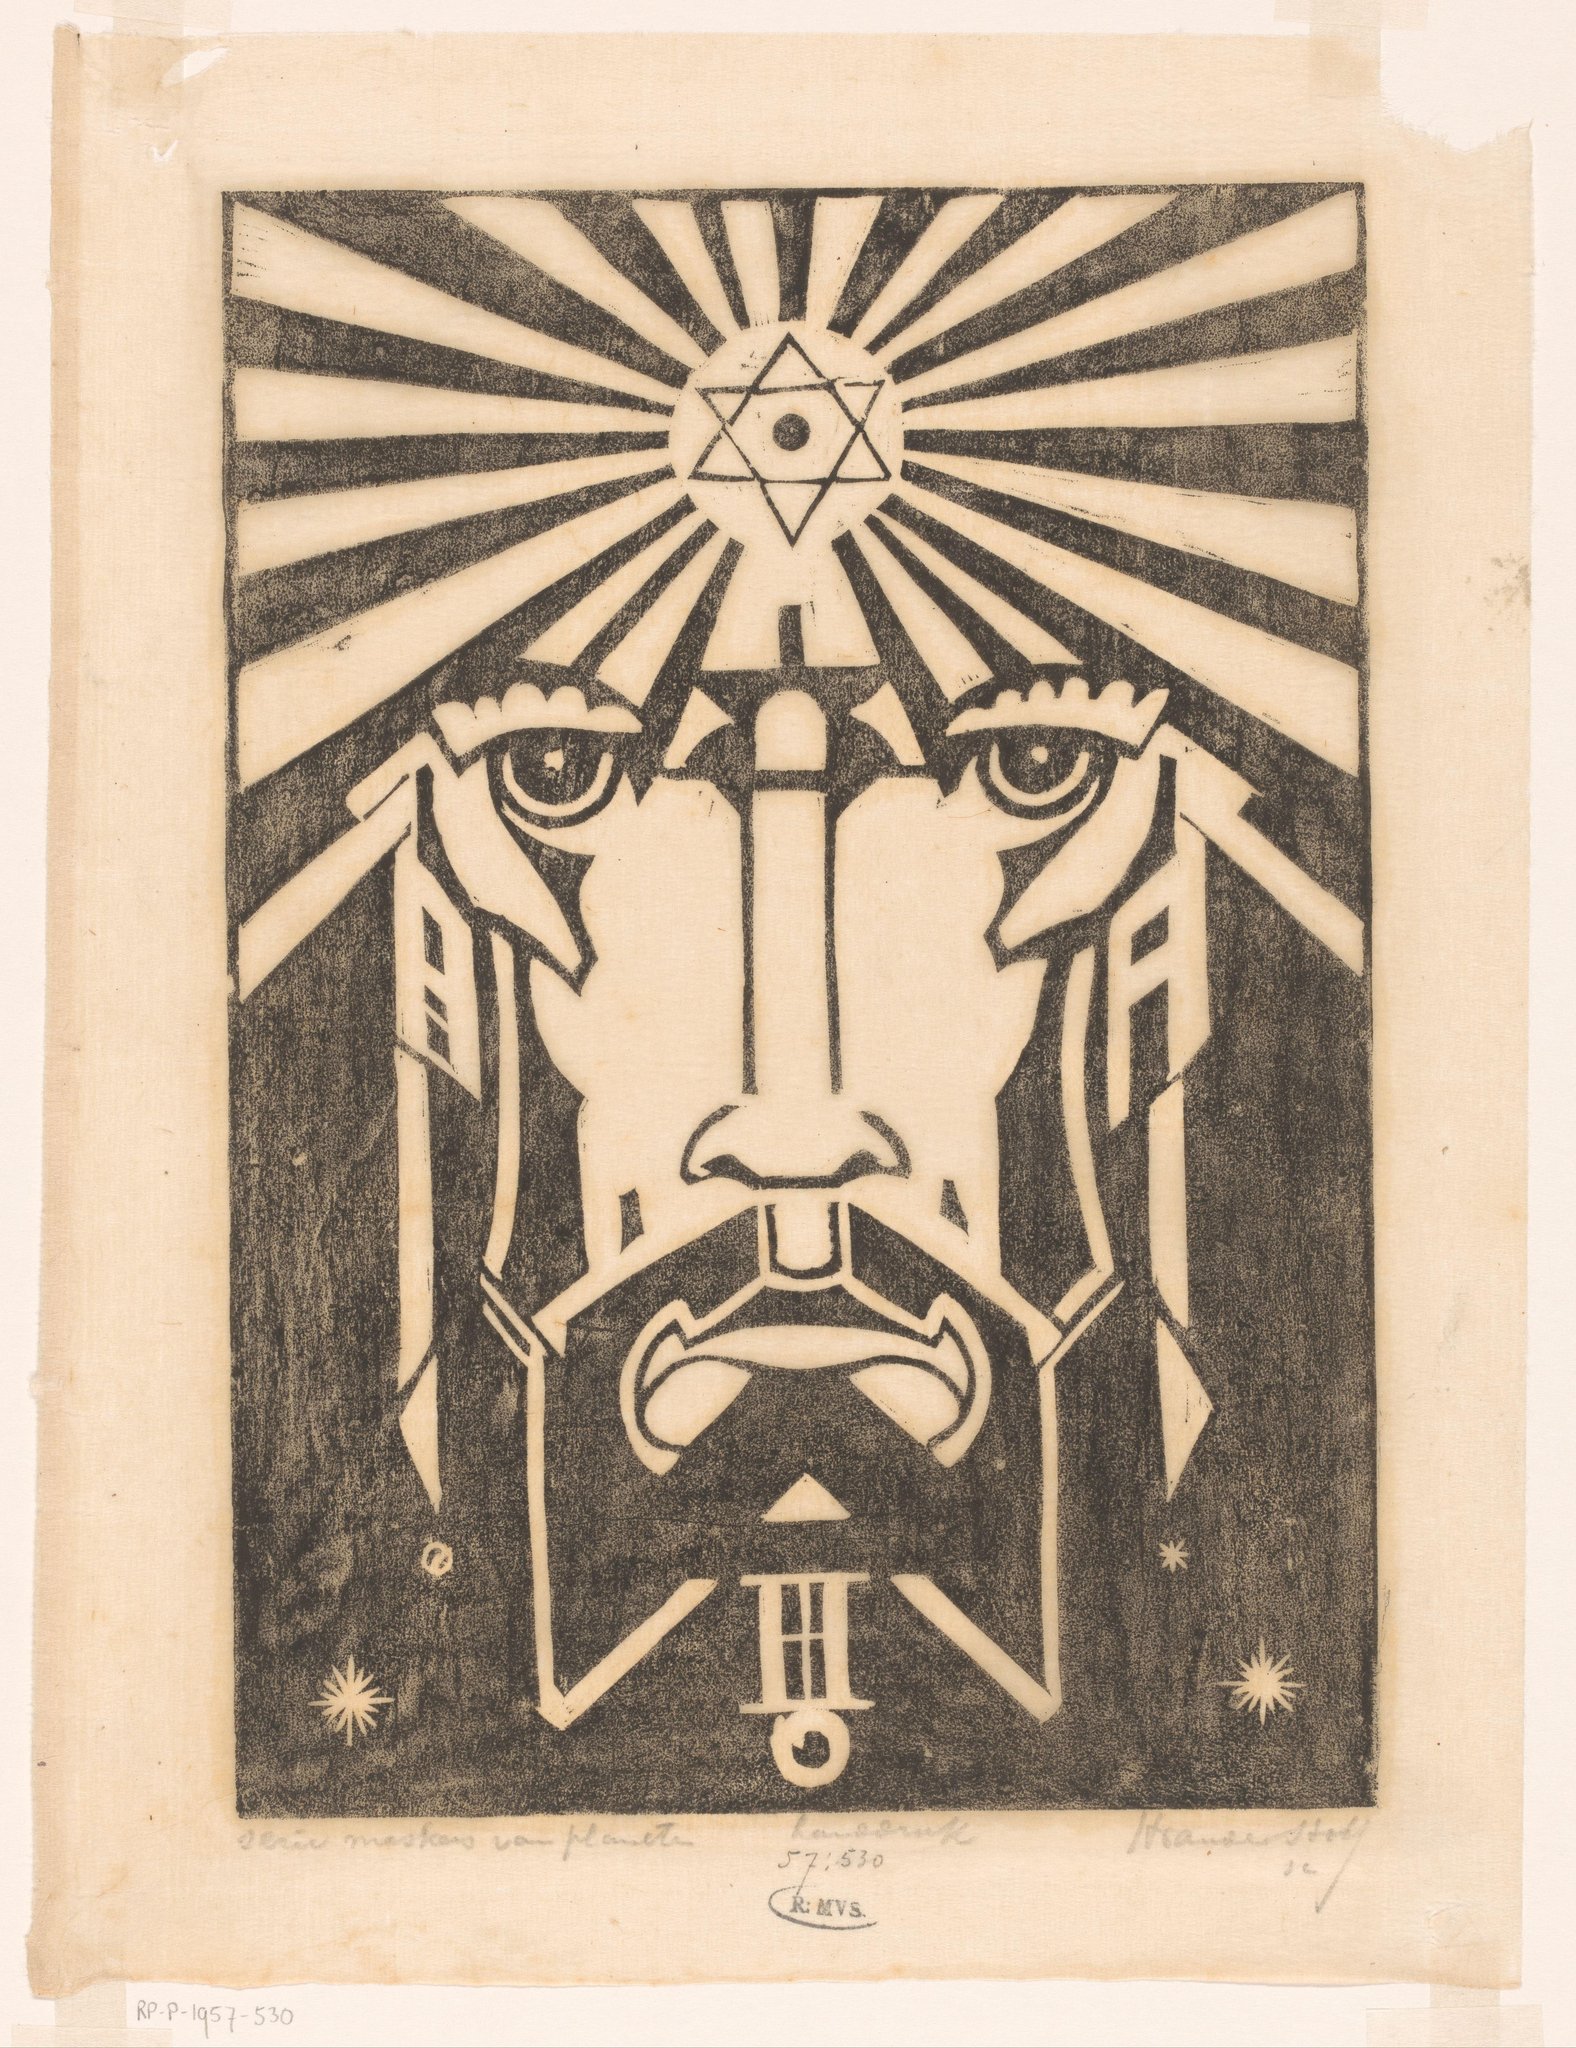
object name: print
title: Uranus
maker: henri van der stok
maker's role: print maker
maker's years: 1870-1946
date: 1880-1946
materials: paper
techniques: woodcut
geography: netherlands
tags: mask, uranus (planet)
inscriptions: inscription: ‘serie maskers van planeten’, collector's mark: Lugt 2228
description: Een masker met een baard en op het voorhoofd een hexagram omgeven door stralen. Onderaan het symbool voor Uranus.